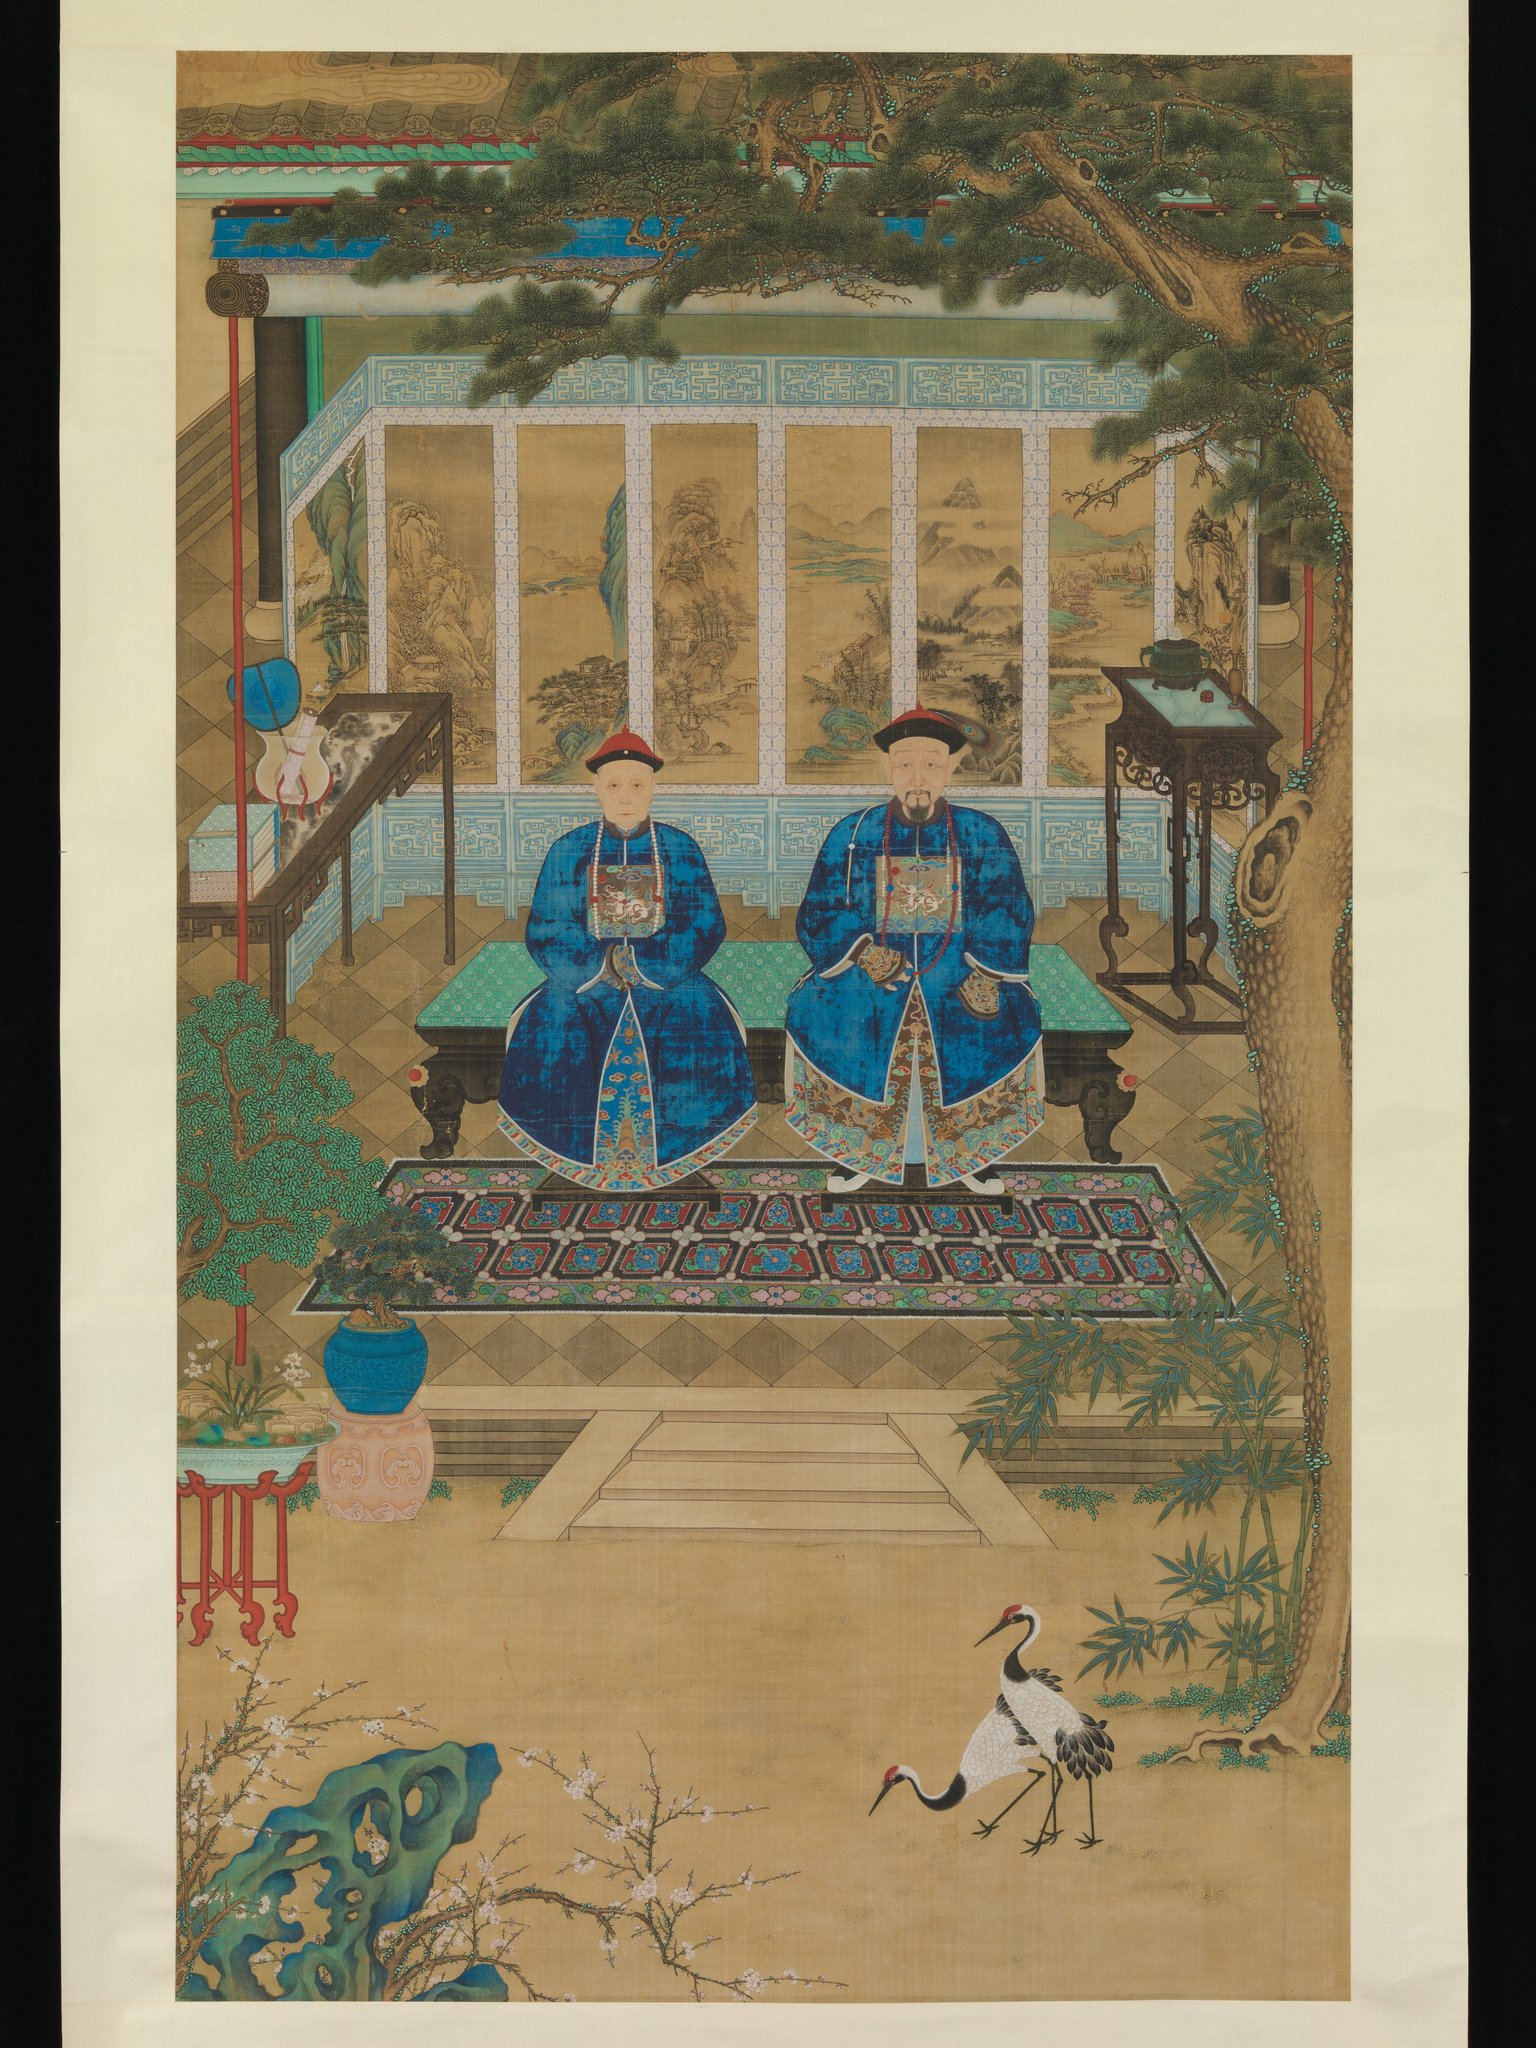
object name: hanging scroll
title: Portrait of husband and wife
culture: chinese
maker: unidentified artist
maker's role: artist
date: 1767-1833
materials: ink, silk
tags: cranes,men,portraits,women,screens,couches,tables